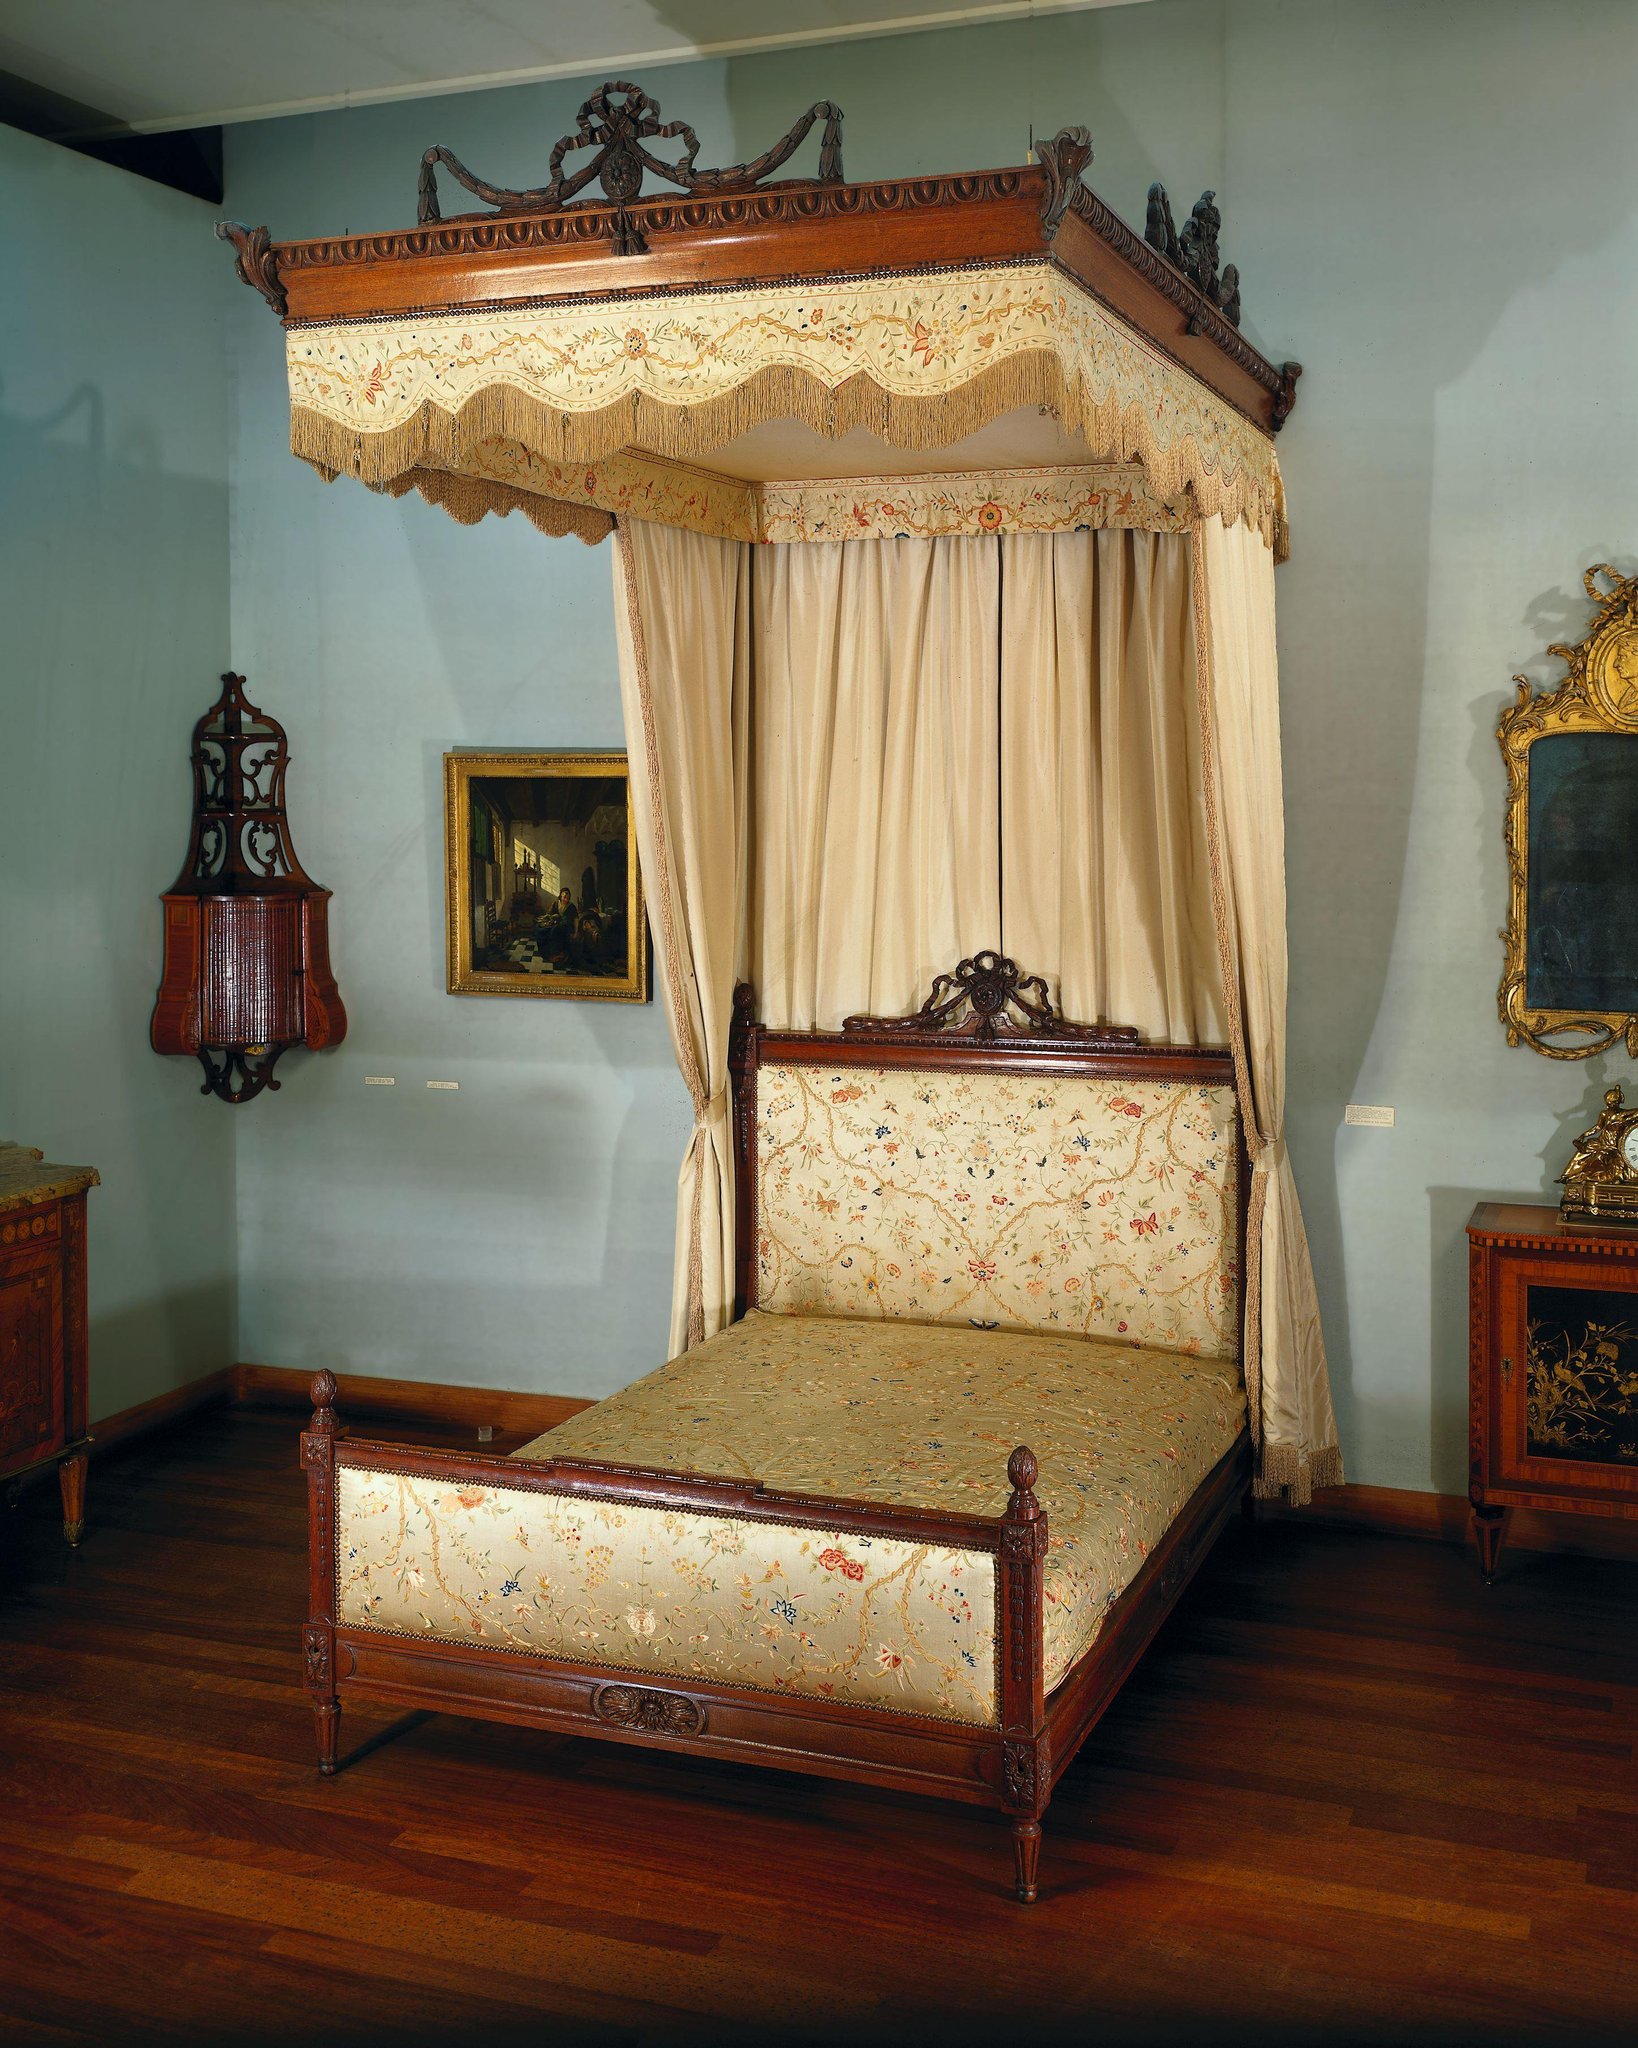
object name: textile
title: Strook, recht, van crème-witte satijn, kleurig geborduurd met een rozet in het midden waarvan aan beide kanten een golvende bloemenrank uitgaat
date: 1750-1800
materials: silk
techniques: embroidered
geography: china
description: Strook, recht, van crème-witte satijn, kleurig geborduurd met een rozet in het midden waarvan aan beide kanten een golvende bloemenrank uitgaat. Chinese zijde.